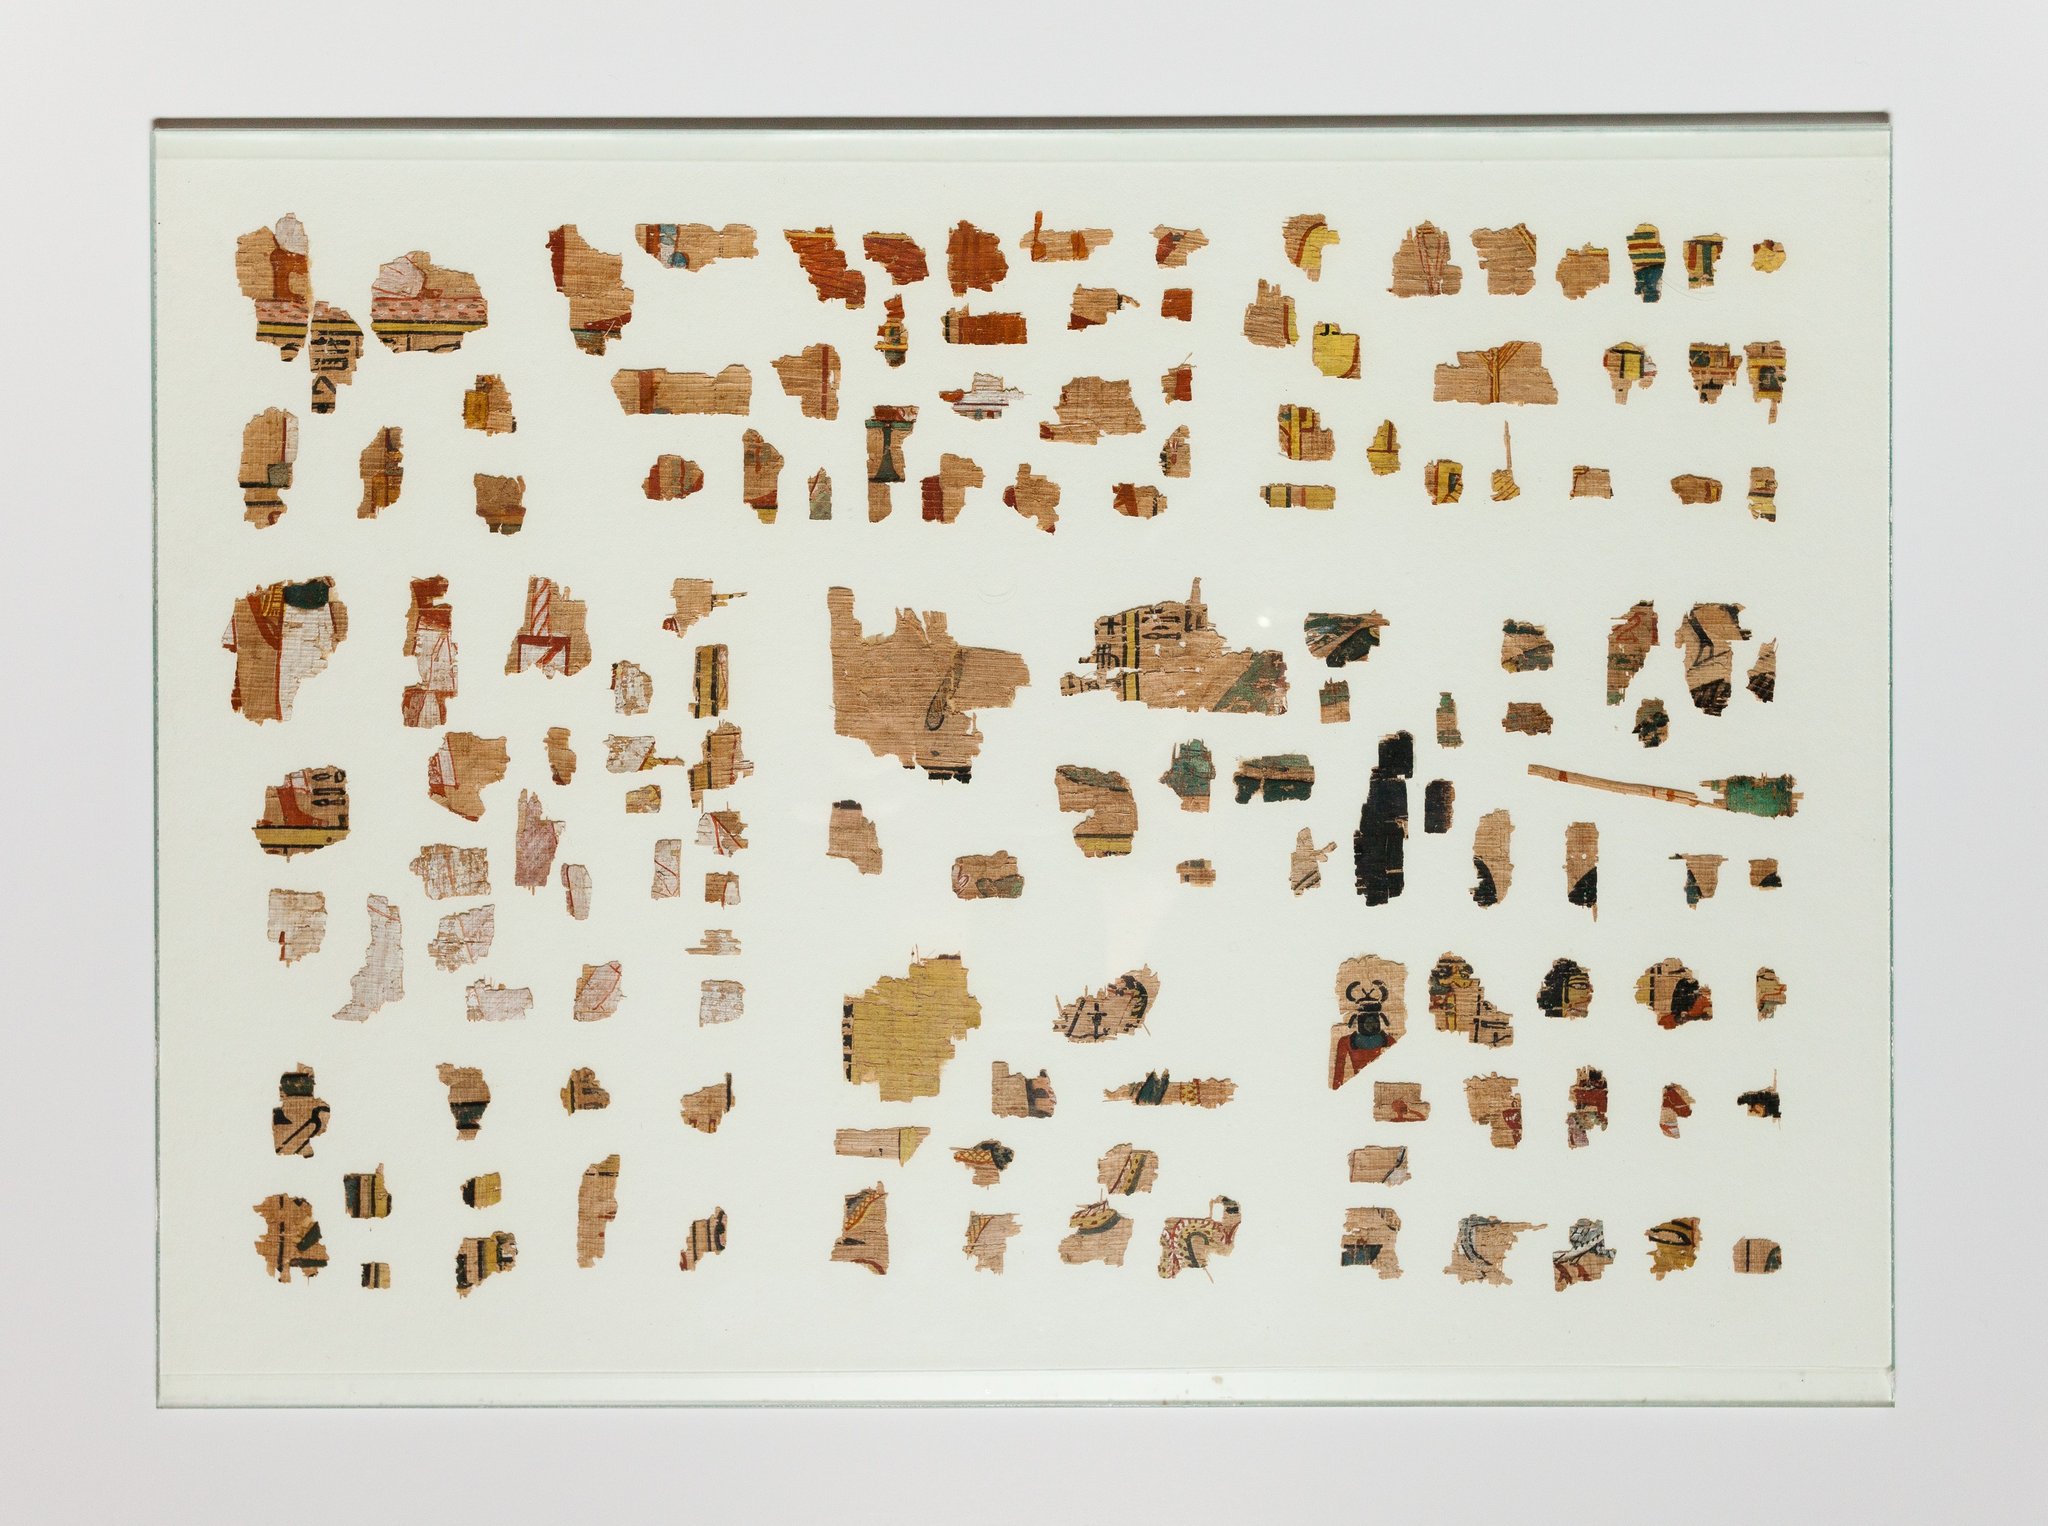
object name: papyrus, funerary, book of the dead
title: Fragments from a Book of the Dead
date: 1390-1353 BCE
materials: ink, papyrus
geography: egypt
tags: hieroglyphs